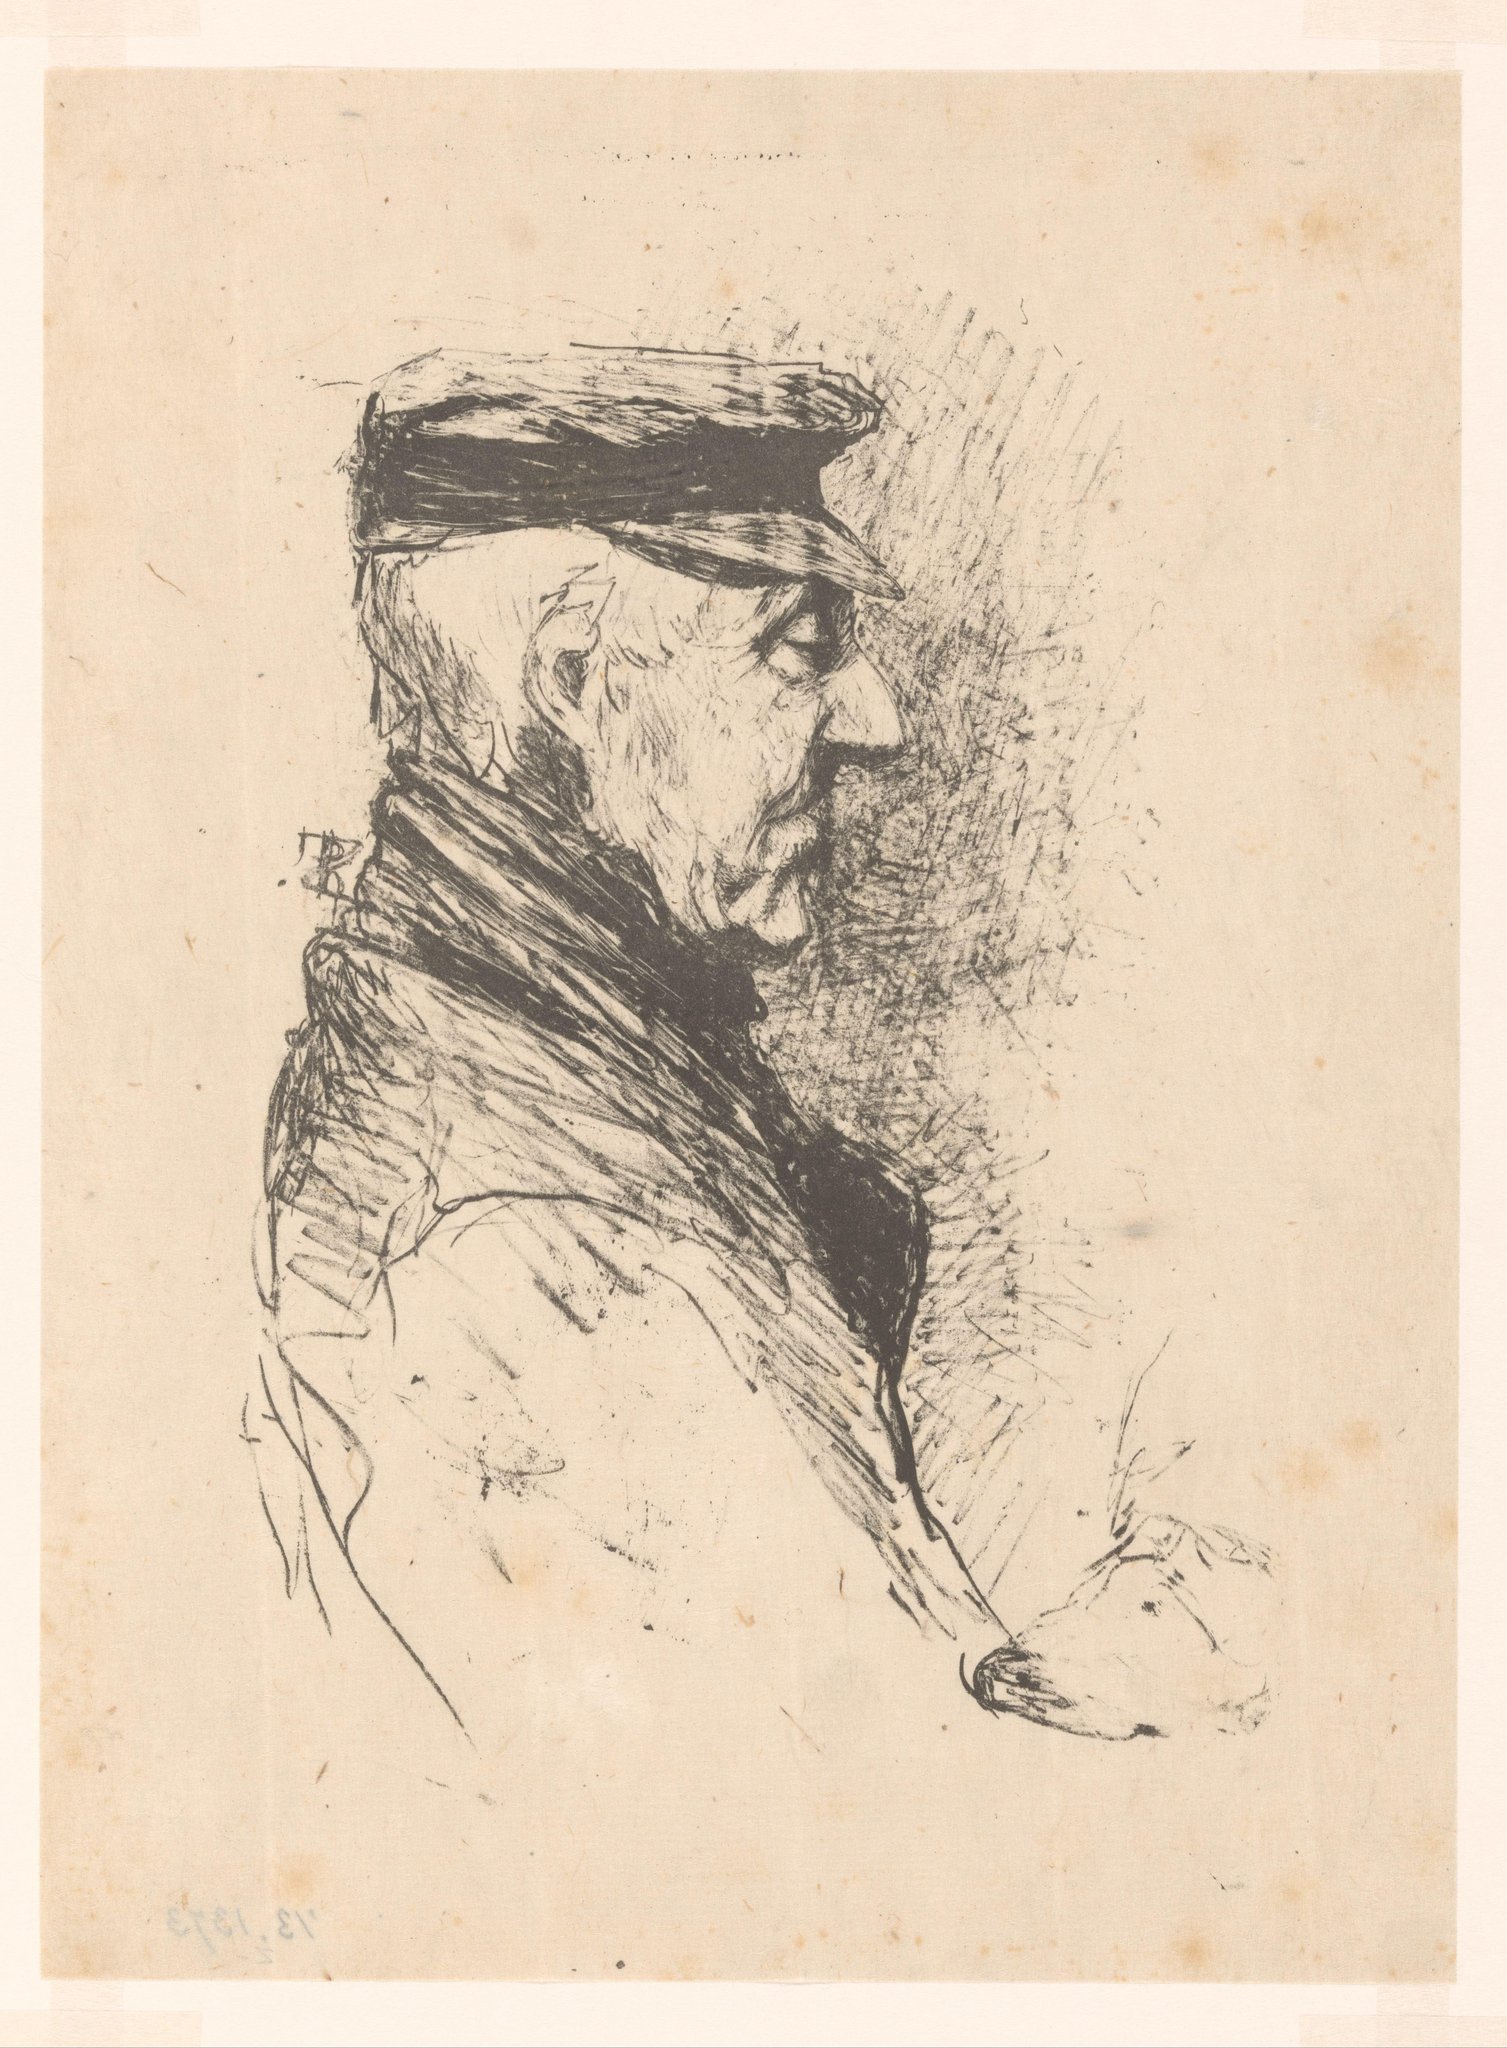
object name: print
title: Oude man met een pet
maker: philip zilcken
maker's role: draughtsman, painter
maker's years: 1857-1930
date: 1867-1913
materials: paper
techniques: soft ground etching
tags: old man